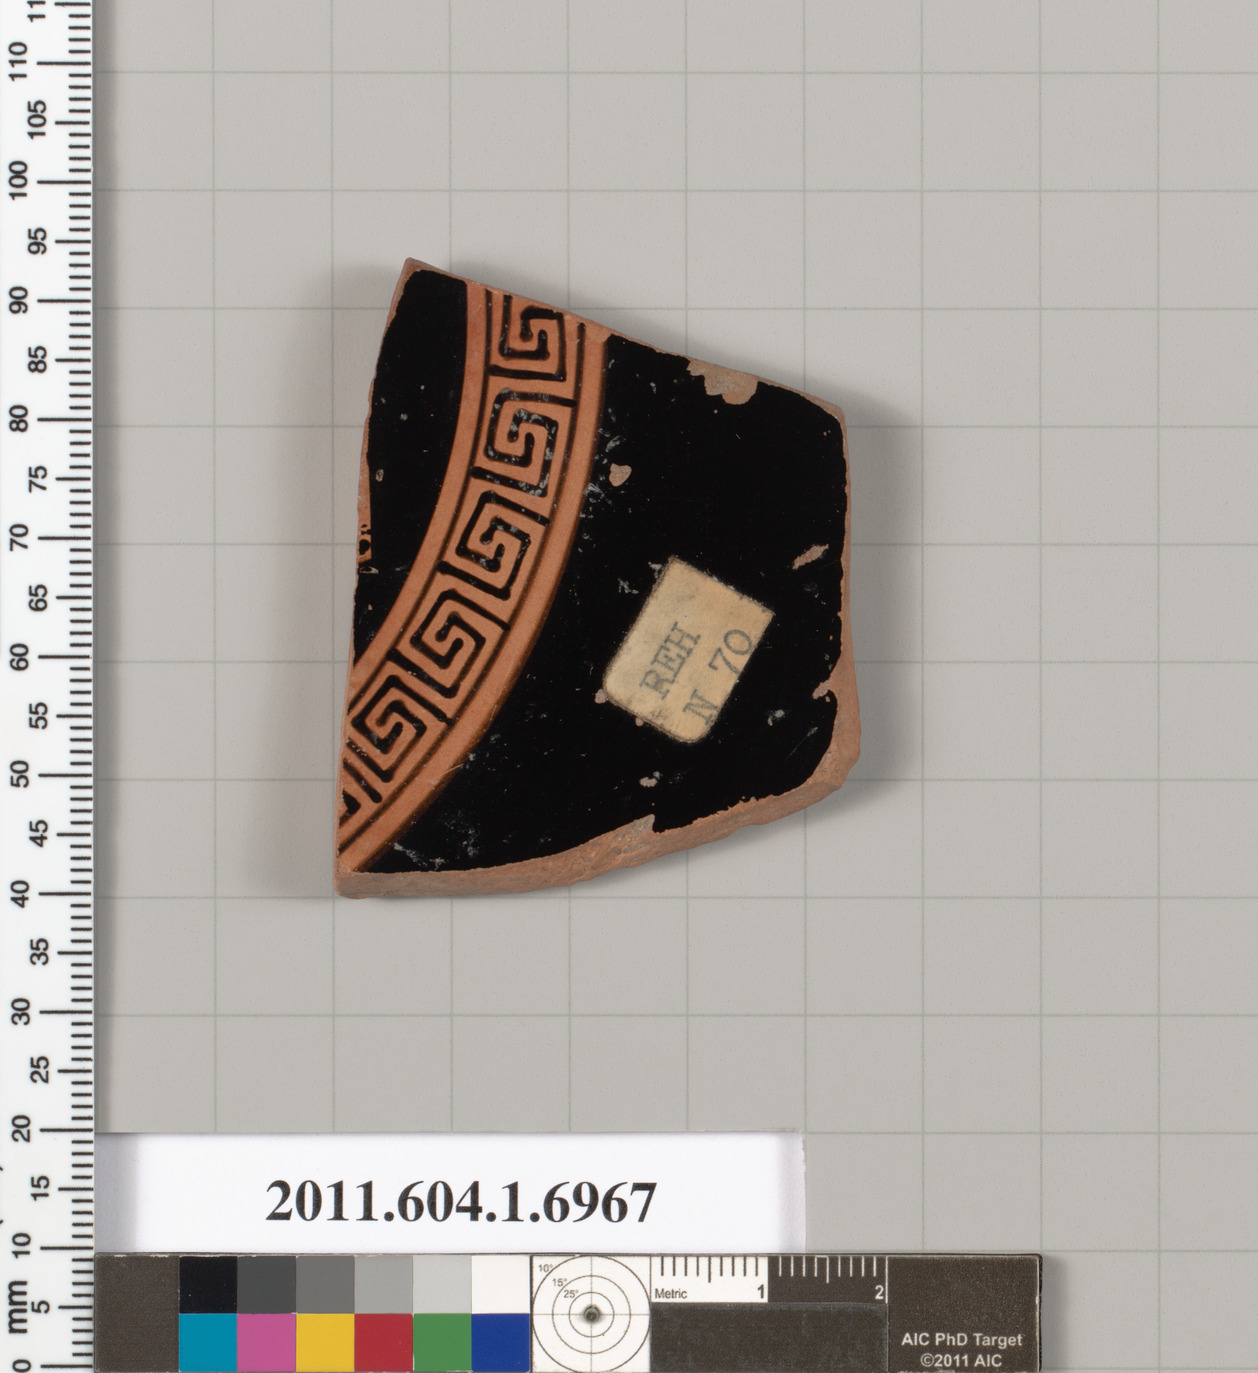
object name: kylix fragment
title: Terracotta fragment of a kylix (drinking cup)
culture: greek, attic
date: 490-470 BCE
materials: terracotta